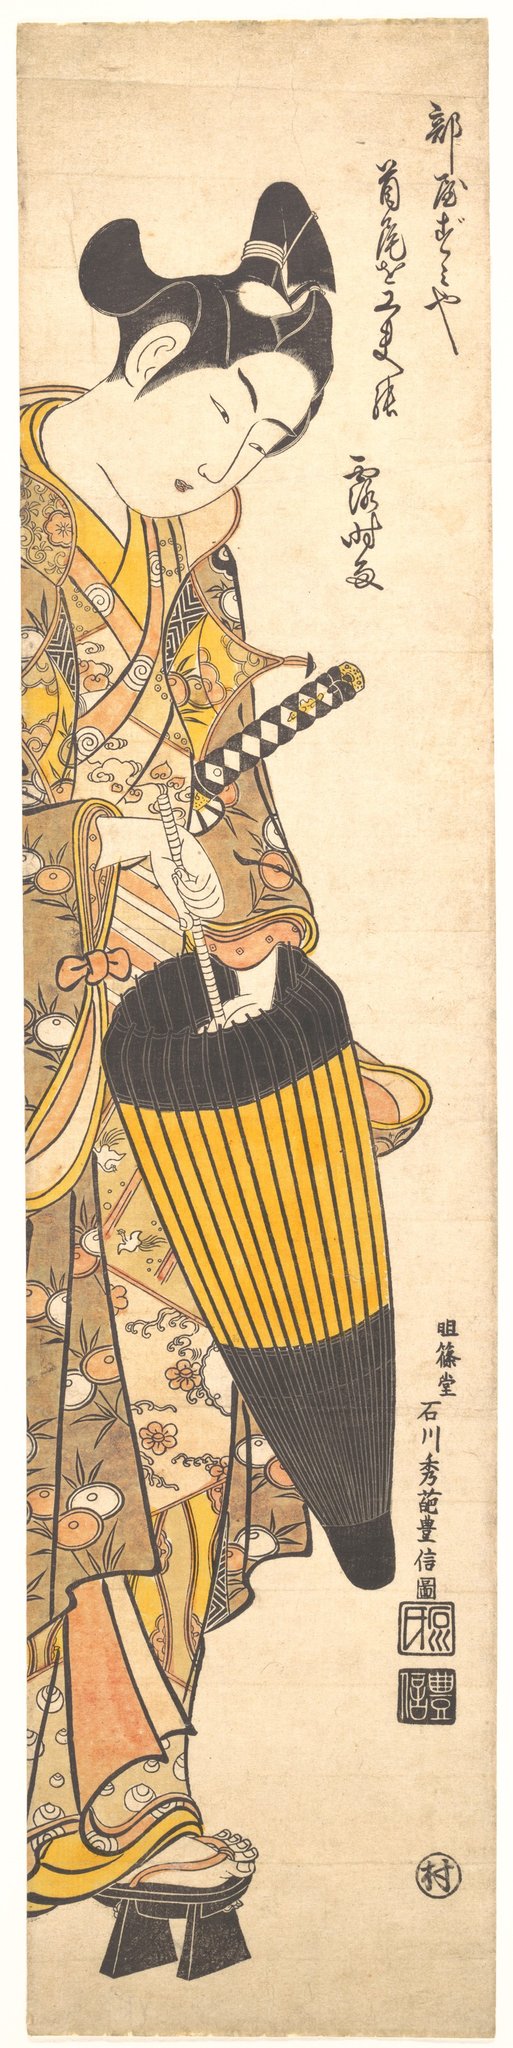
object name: print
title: Young Man Moving Toward the Right on High Geta and Opening His Umbrella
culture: japanese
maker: ishikawa toyonobu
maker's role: artist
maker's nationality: japanese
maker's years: 1711-1785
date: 1745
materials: ink, paper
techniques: hand coloring, woodblock print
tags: men,walking